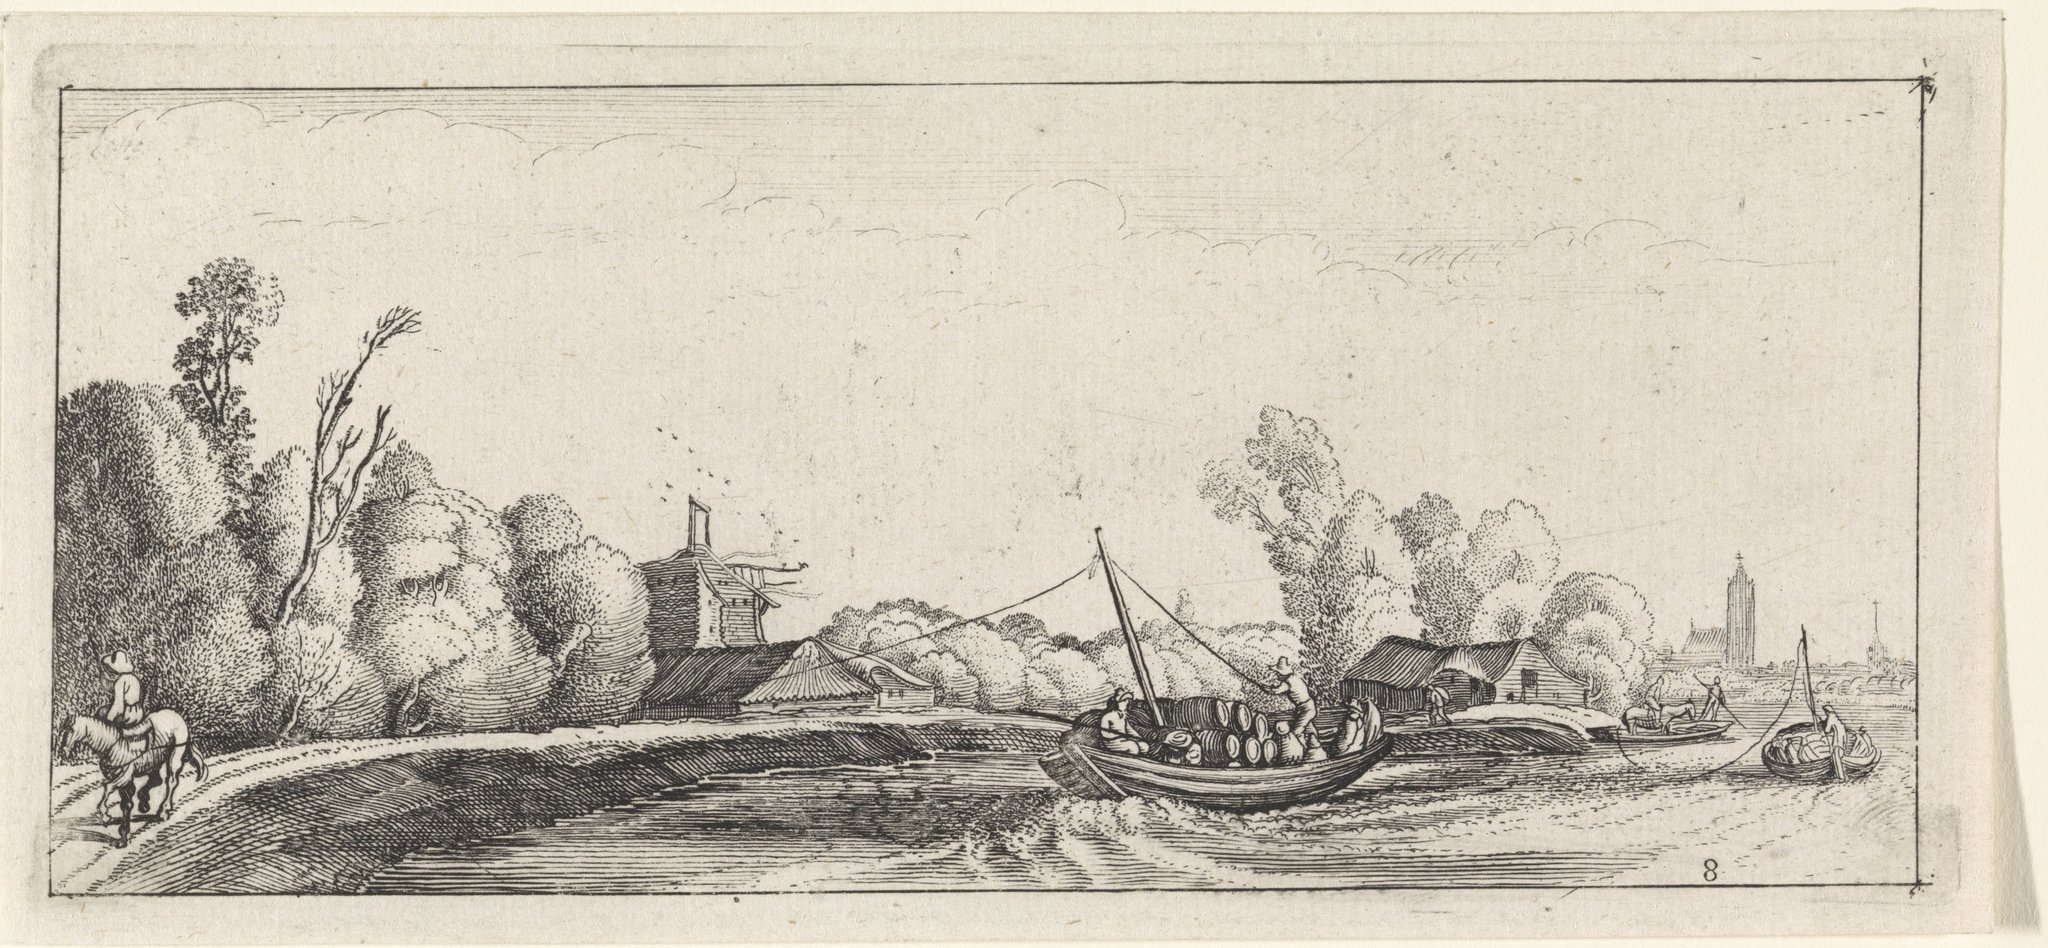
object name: print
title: Riviergezicht met trekschuiten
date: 1627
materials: paper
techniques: engraving, etching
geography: northern netherlands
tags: tow-boat, towing-barge, towing path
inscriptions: collector's mark: Lugt 240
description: Prent ook gebruikt als boekillustratie in: Campanus, M., Colevelt, J.J. Craen, A.P., Robbertzen, J. Amsterdamsche Pegasus, waer in (uyt lust) byeen vergadert zijn veel minnelycke liedekens. Amsterdam: Cornelis Willemsz Blaeu-laken, 1627.